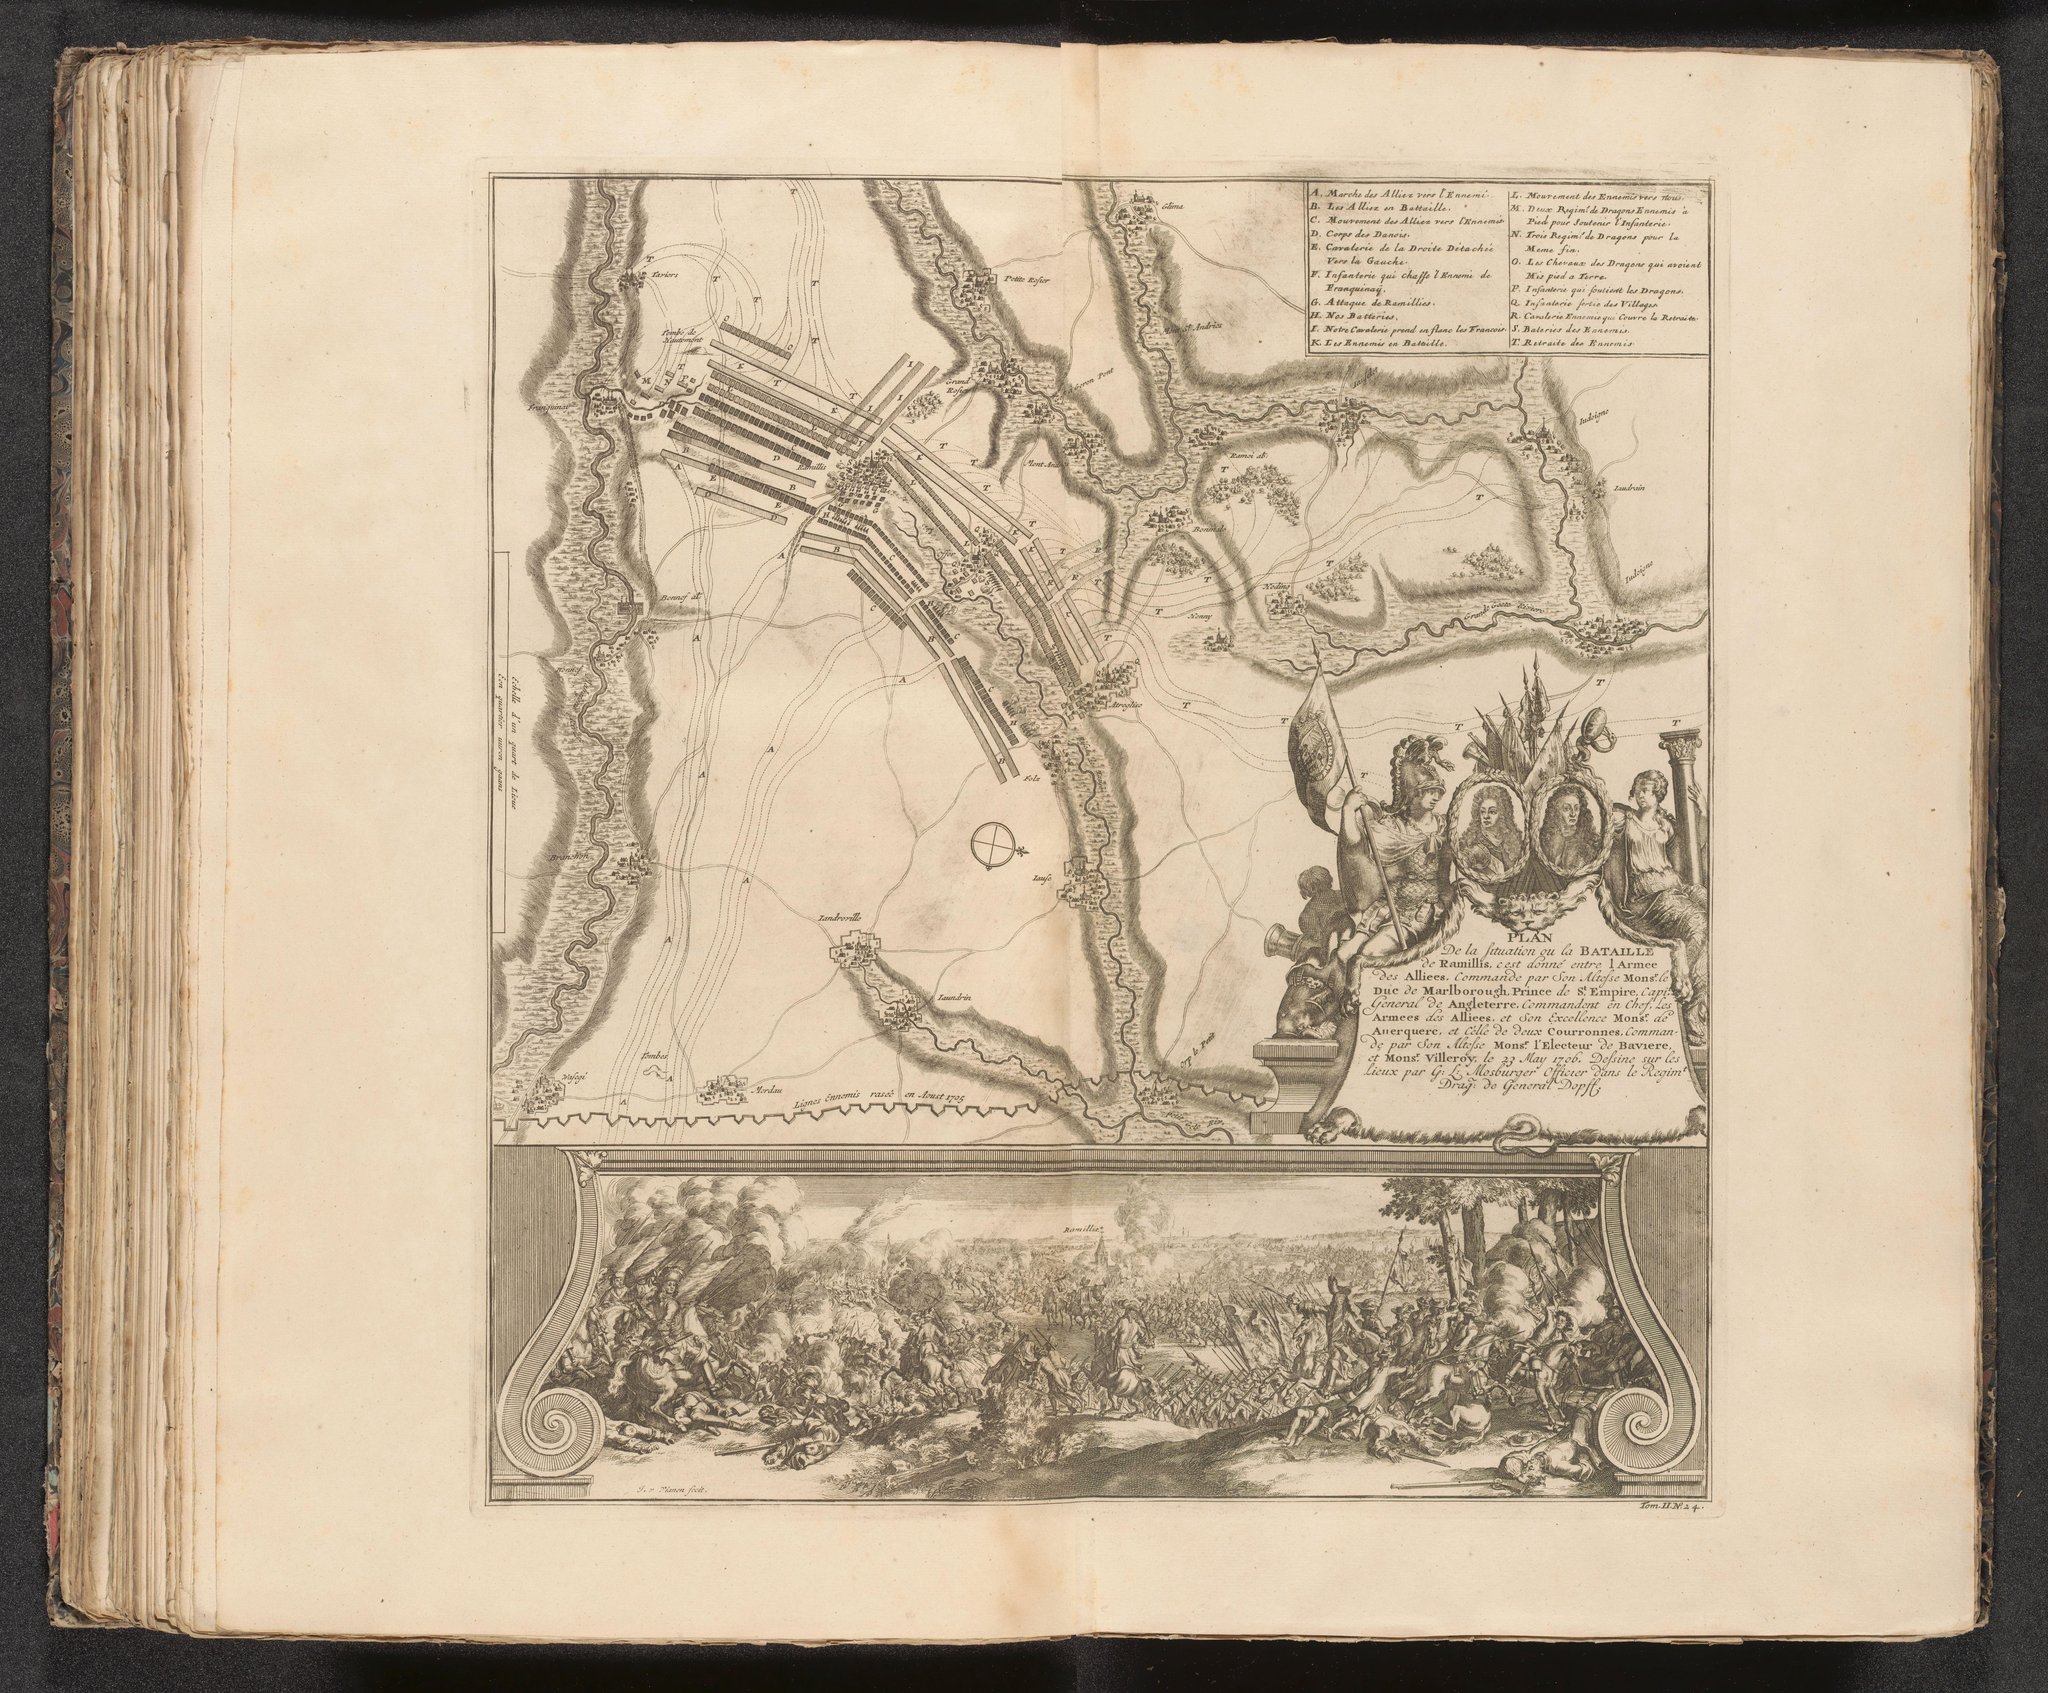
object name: print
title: Plan De la situation ou la Bataille de Ramillis, c'est donné entre l Armee des Alliees (...) 23 May 1706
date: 1706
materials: paper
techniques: etching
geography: the hague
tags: johan willem friso (prins van oranje-nassau), john churchill (1e hertog van marlborough), the hague, maps of separate countries or regions, battle (+ land forces)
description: Plan en gezicht van de slag bij Ramillies tussen de Geallieerden onder de hertog van Marlborough en Hendrik van Nassau, heer van Ouwerkerk en de Fransen en de Beiersen, 23 mei 1706. Rechts een cartouche versierd met allegorische figuren en de portretten van Marlborough en Ouwerkerk. Genummerd rechtsonder: Tom. II. No. 24. Illustratie in het tweede deel van : [Jean] du Mont, Oorlogskundige beschryving van de veldslagen en belegeringen, der drie ... wydvermaarde krygsoversten... den Prins Eugenius van Savoye, den ... Hertog van Marlborough, en den Prins van Oranje en Nassau-Vriesland, in de editie van 1729. Dit tweede deel is hoofdzakelijk gewijd aan de daden van de hertog van Marlborough en prins Johan Willem Friso.